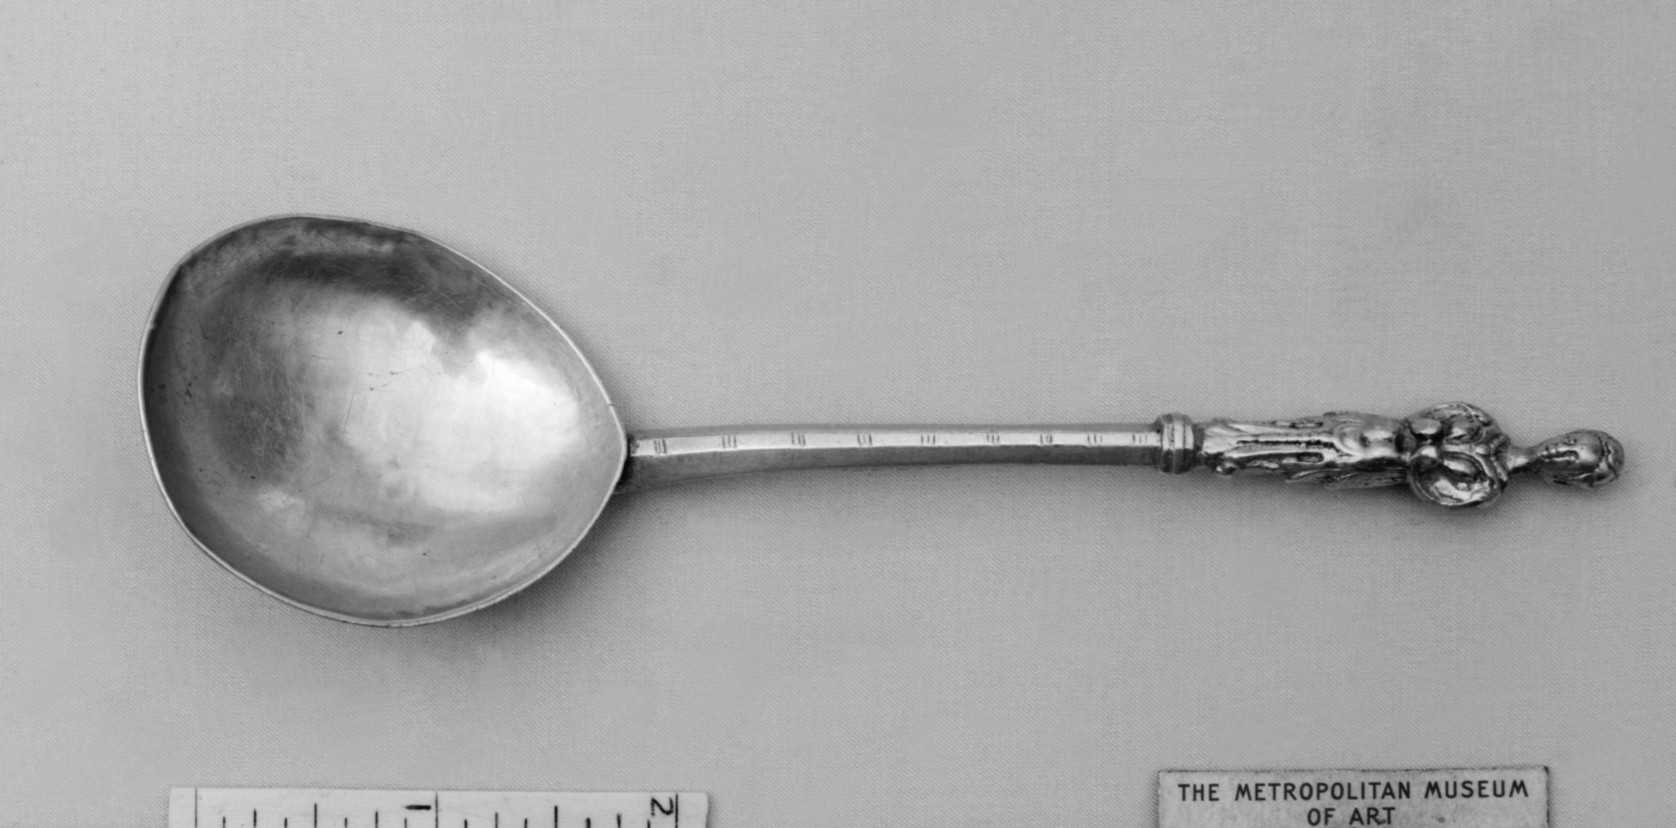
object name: spoon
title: Figure-top spoon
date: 1667-1700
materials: silver gilt